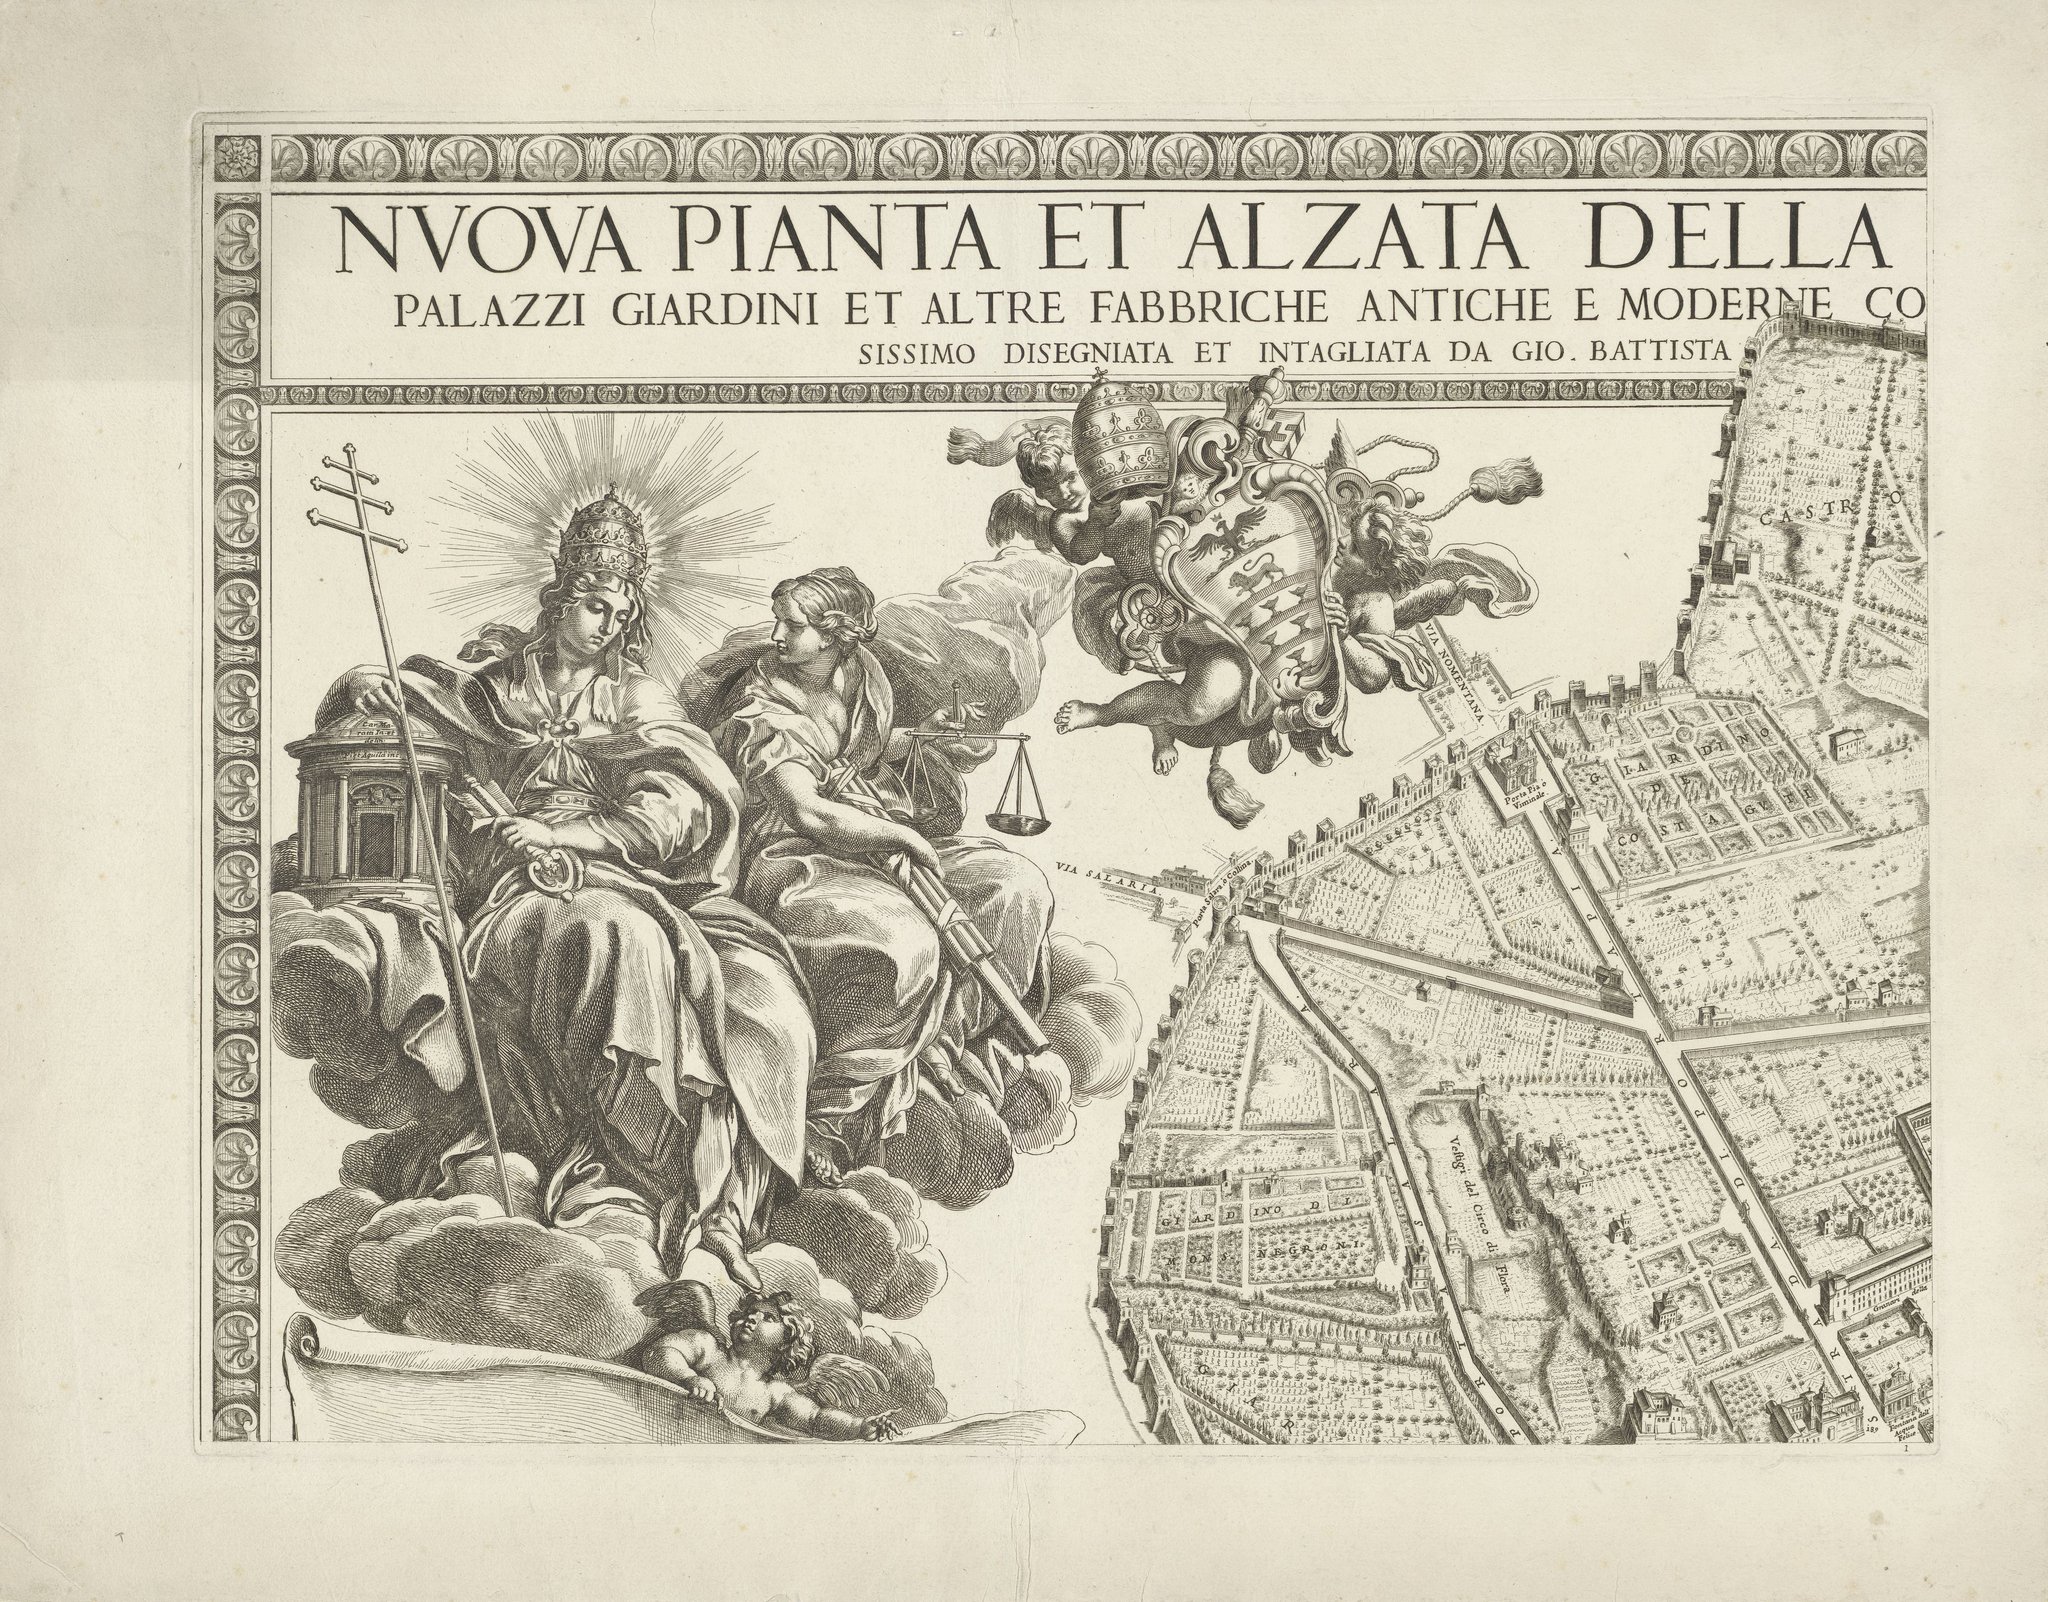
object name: print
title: Plattegrond van de stad Rome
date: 1676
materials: paper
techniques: etching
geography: vatican city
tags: justice, 'justitia'; 'giustitia divina' (ripa) ~ one of the four cardinal virtues, faith, 'fides'; 'fede', 'fede catholica', 'fede christiana', 'fede christiana catholica' (ripa) ~ one of the three theological virtues, maps, atlases, cupids: 'amores', 'amoretti', 'putti', rome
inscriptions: date